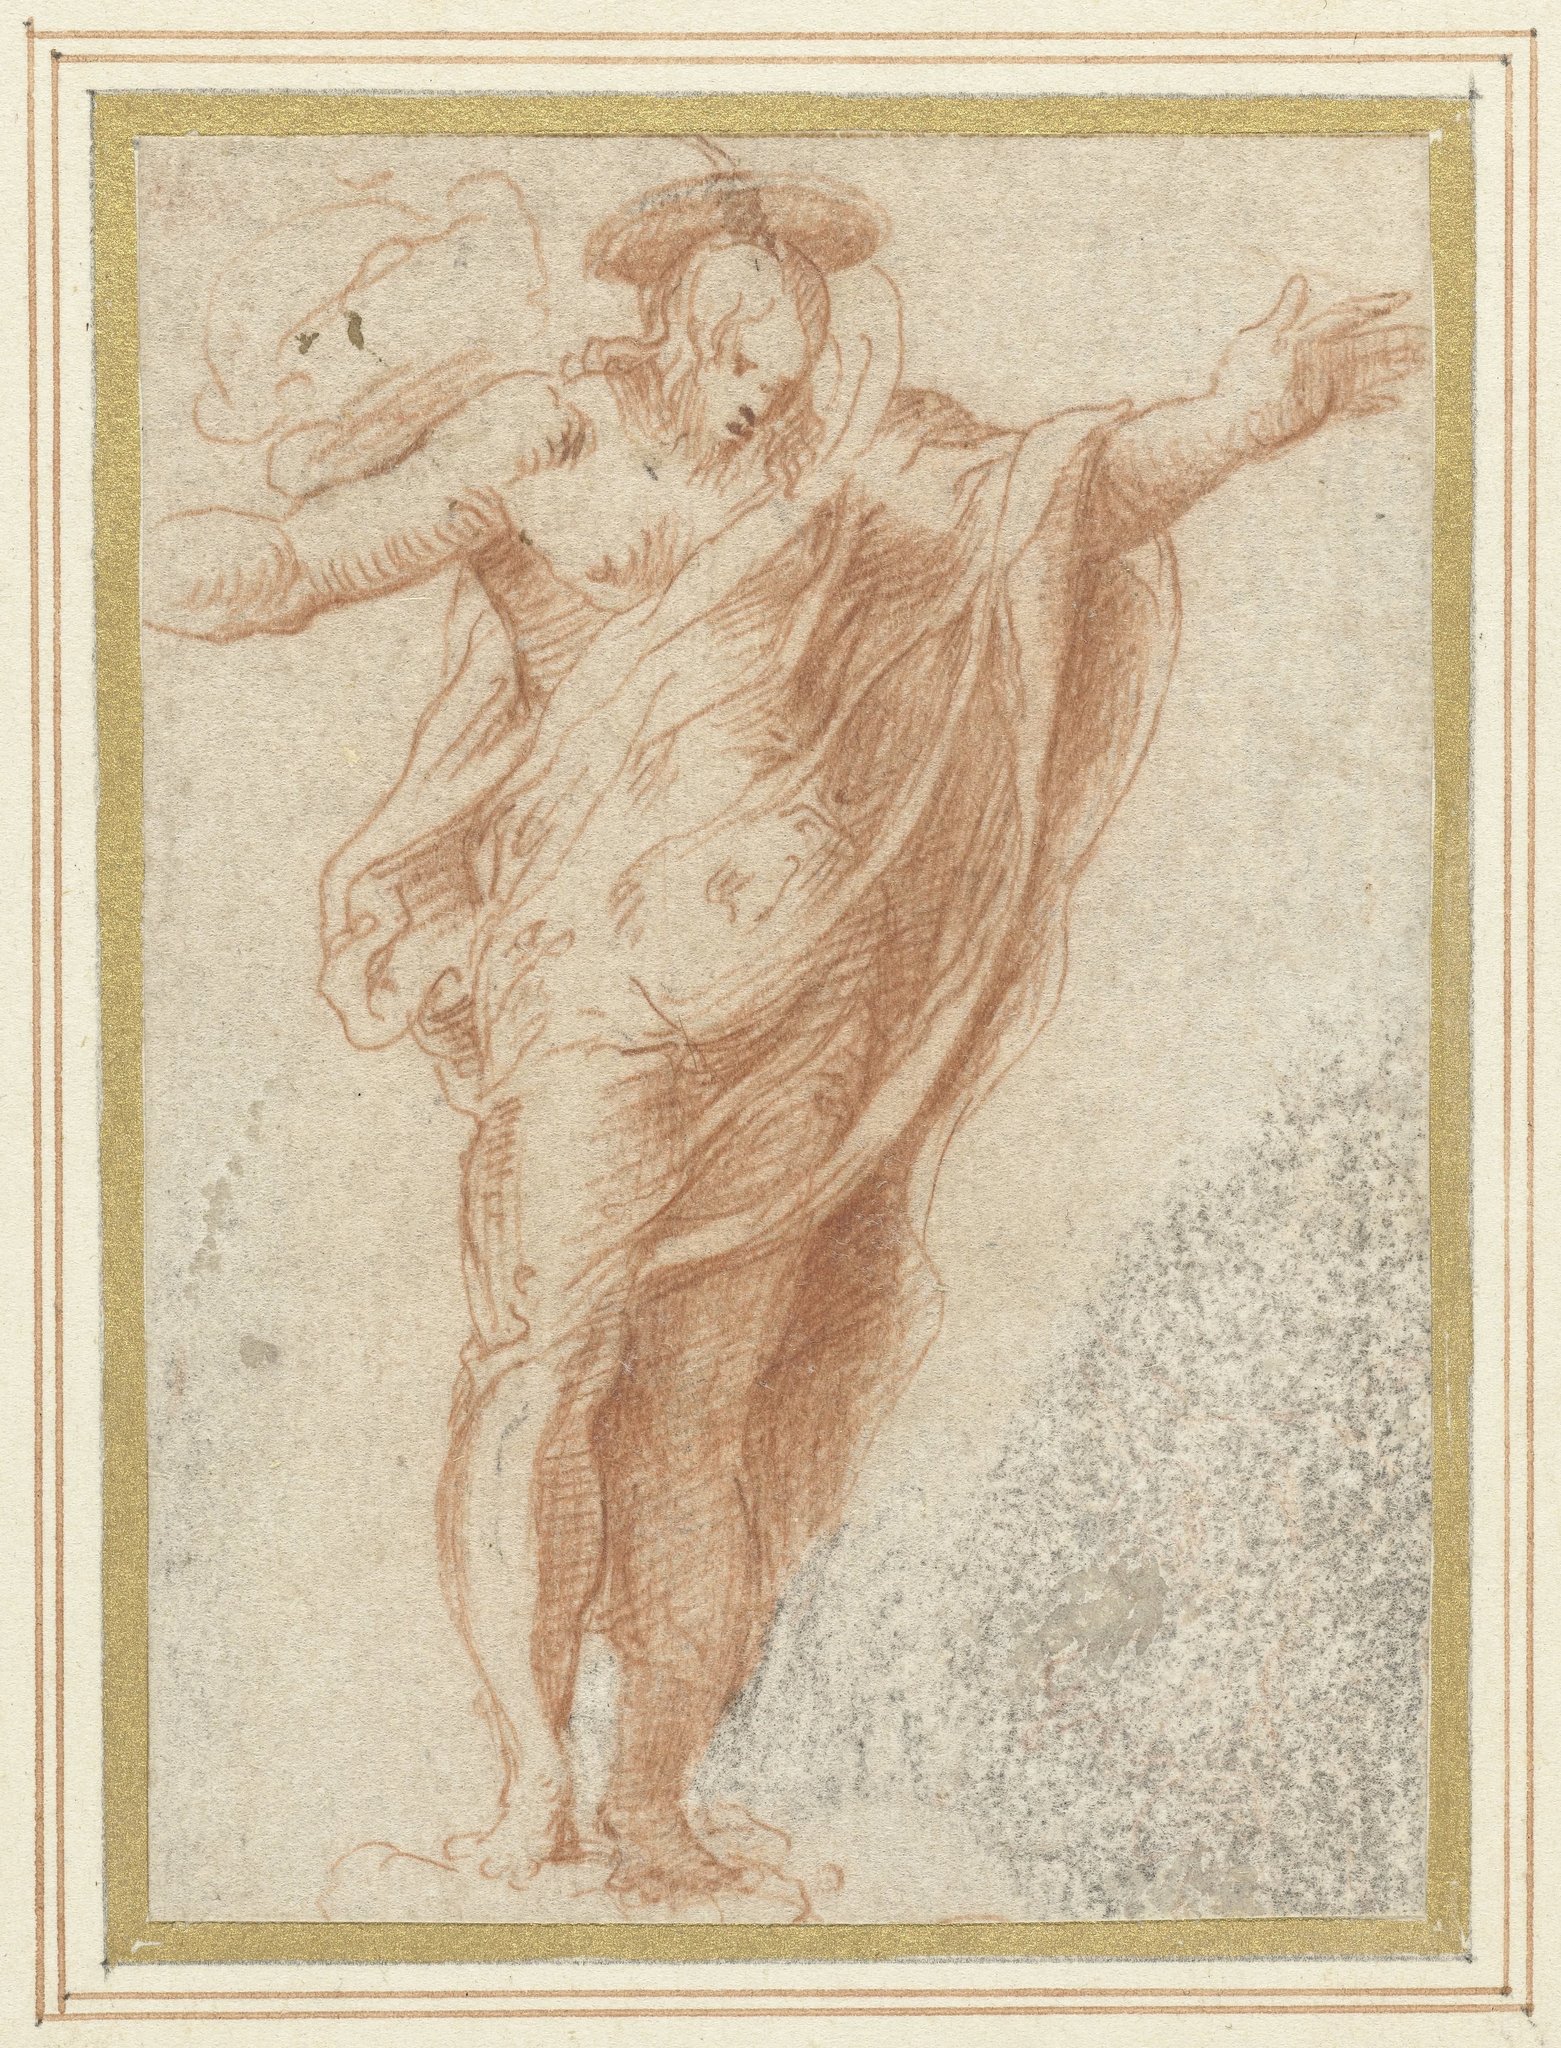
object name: drawing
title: Zegenende Christus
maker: Anonymous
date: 1510-1600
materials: chalk, paper